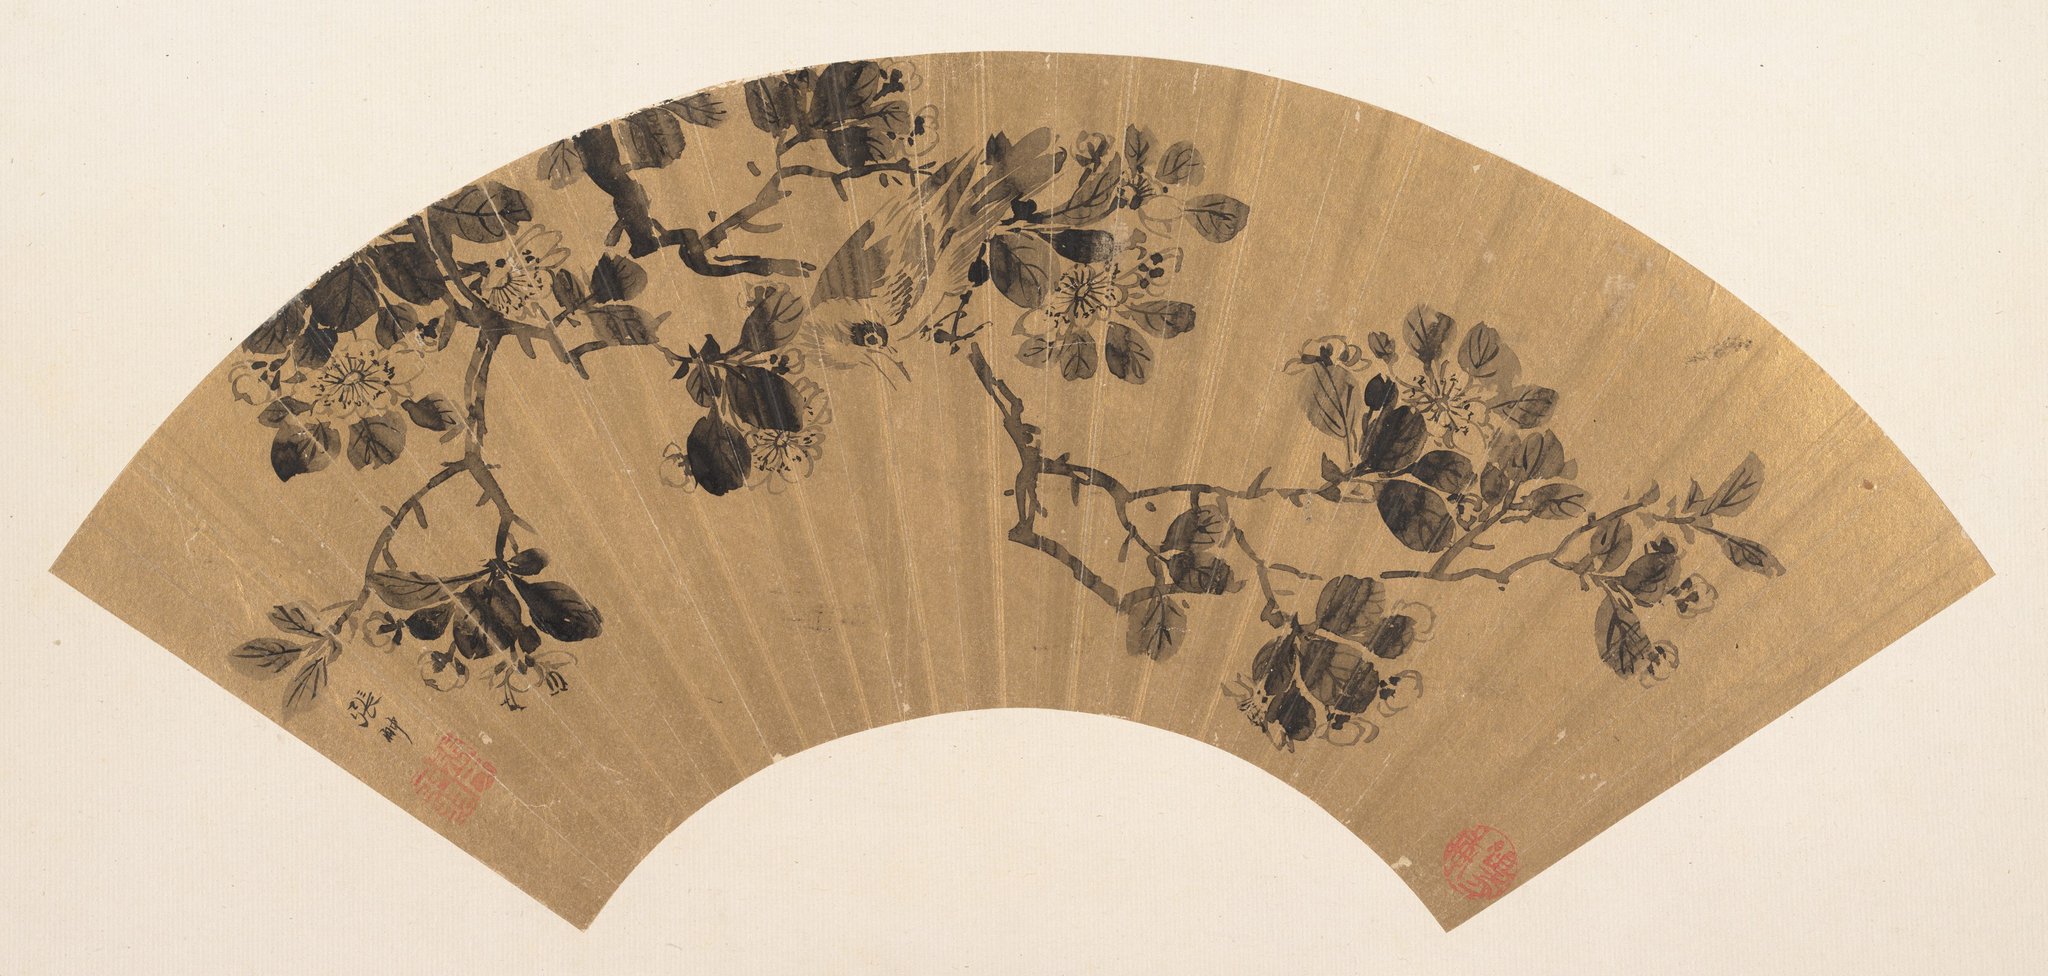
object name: folding fan mounted a an album leaf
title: Bird on a flowering branch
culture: chinese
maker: zhang chong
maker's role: artist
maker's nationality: chinese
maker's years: 1570-1610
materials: gold, ink, paper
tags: birds,flowers